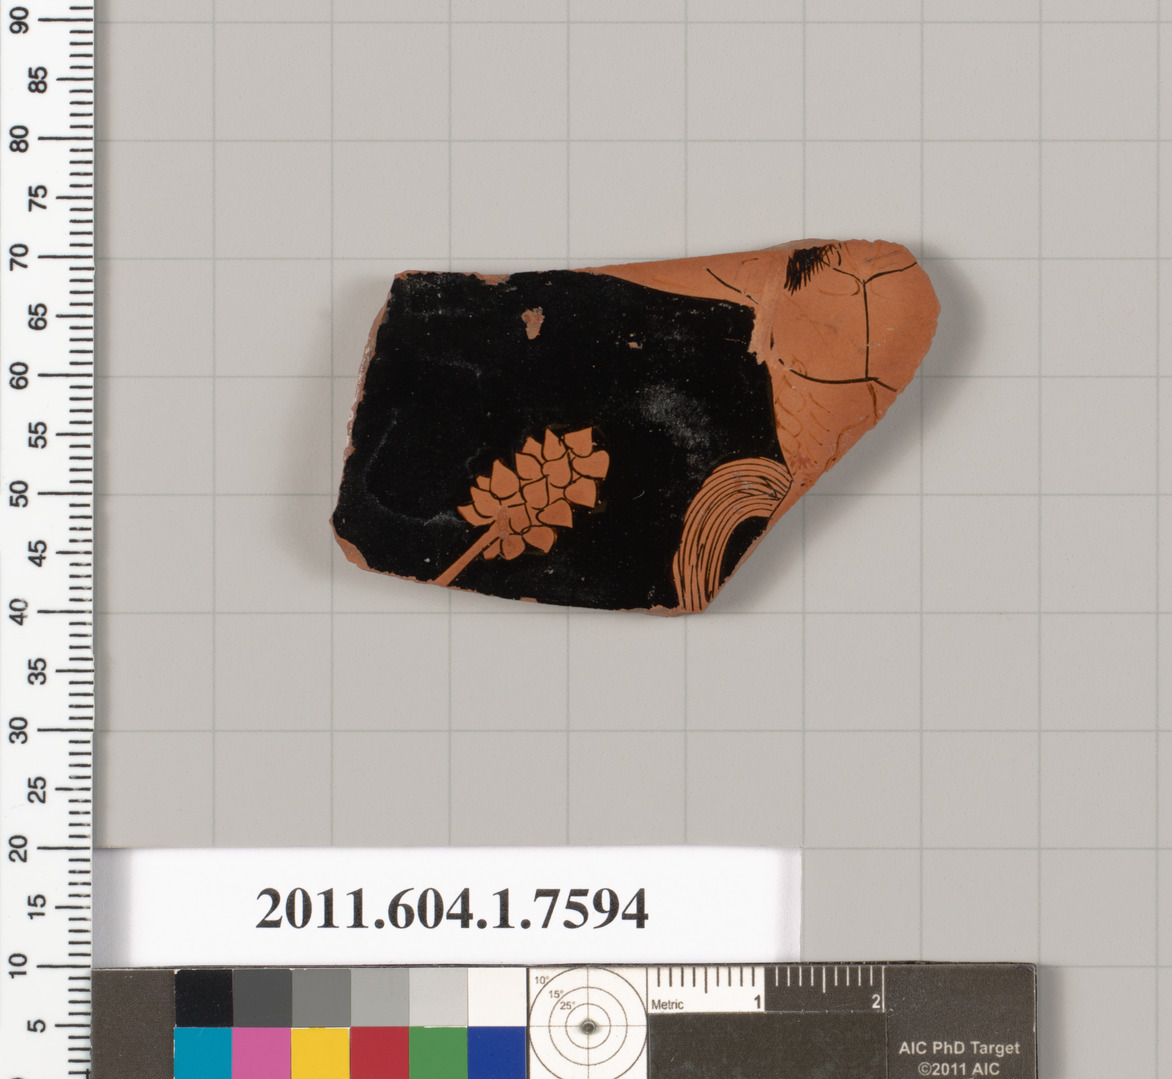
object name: kylix fragment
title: Terracotta fragment of a kylix (drinking cup)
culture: greek, attic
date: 460-450 BCE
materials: terracotta